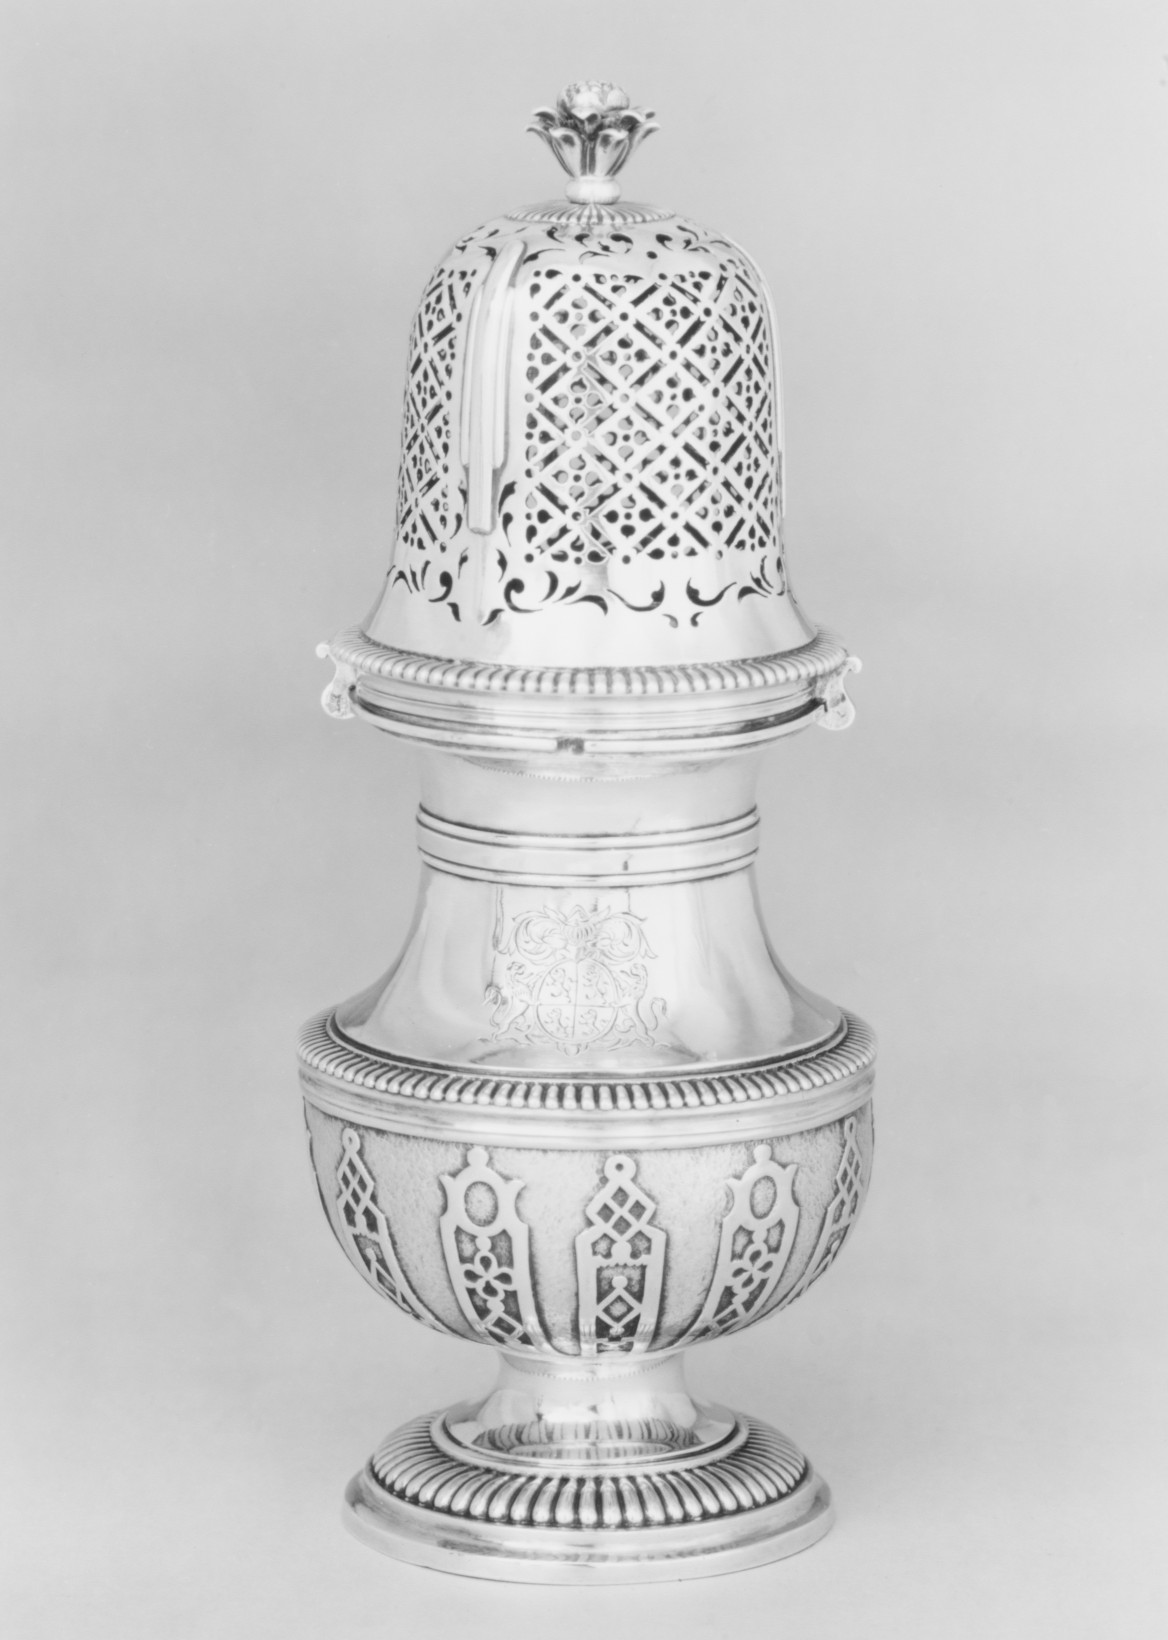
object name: sugar caster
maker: jean lacère (lasserre), père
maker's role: maker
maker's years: 1656-1756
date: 1732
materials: silver